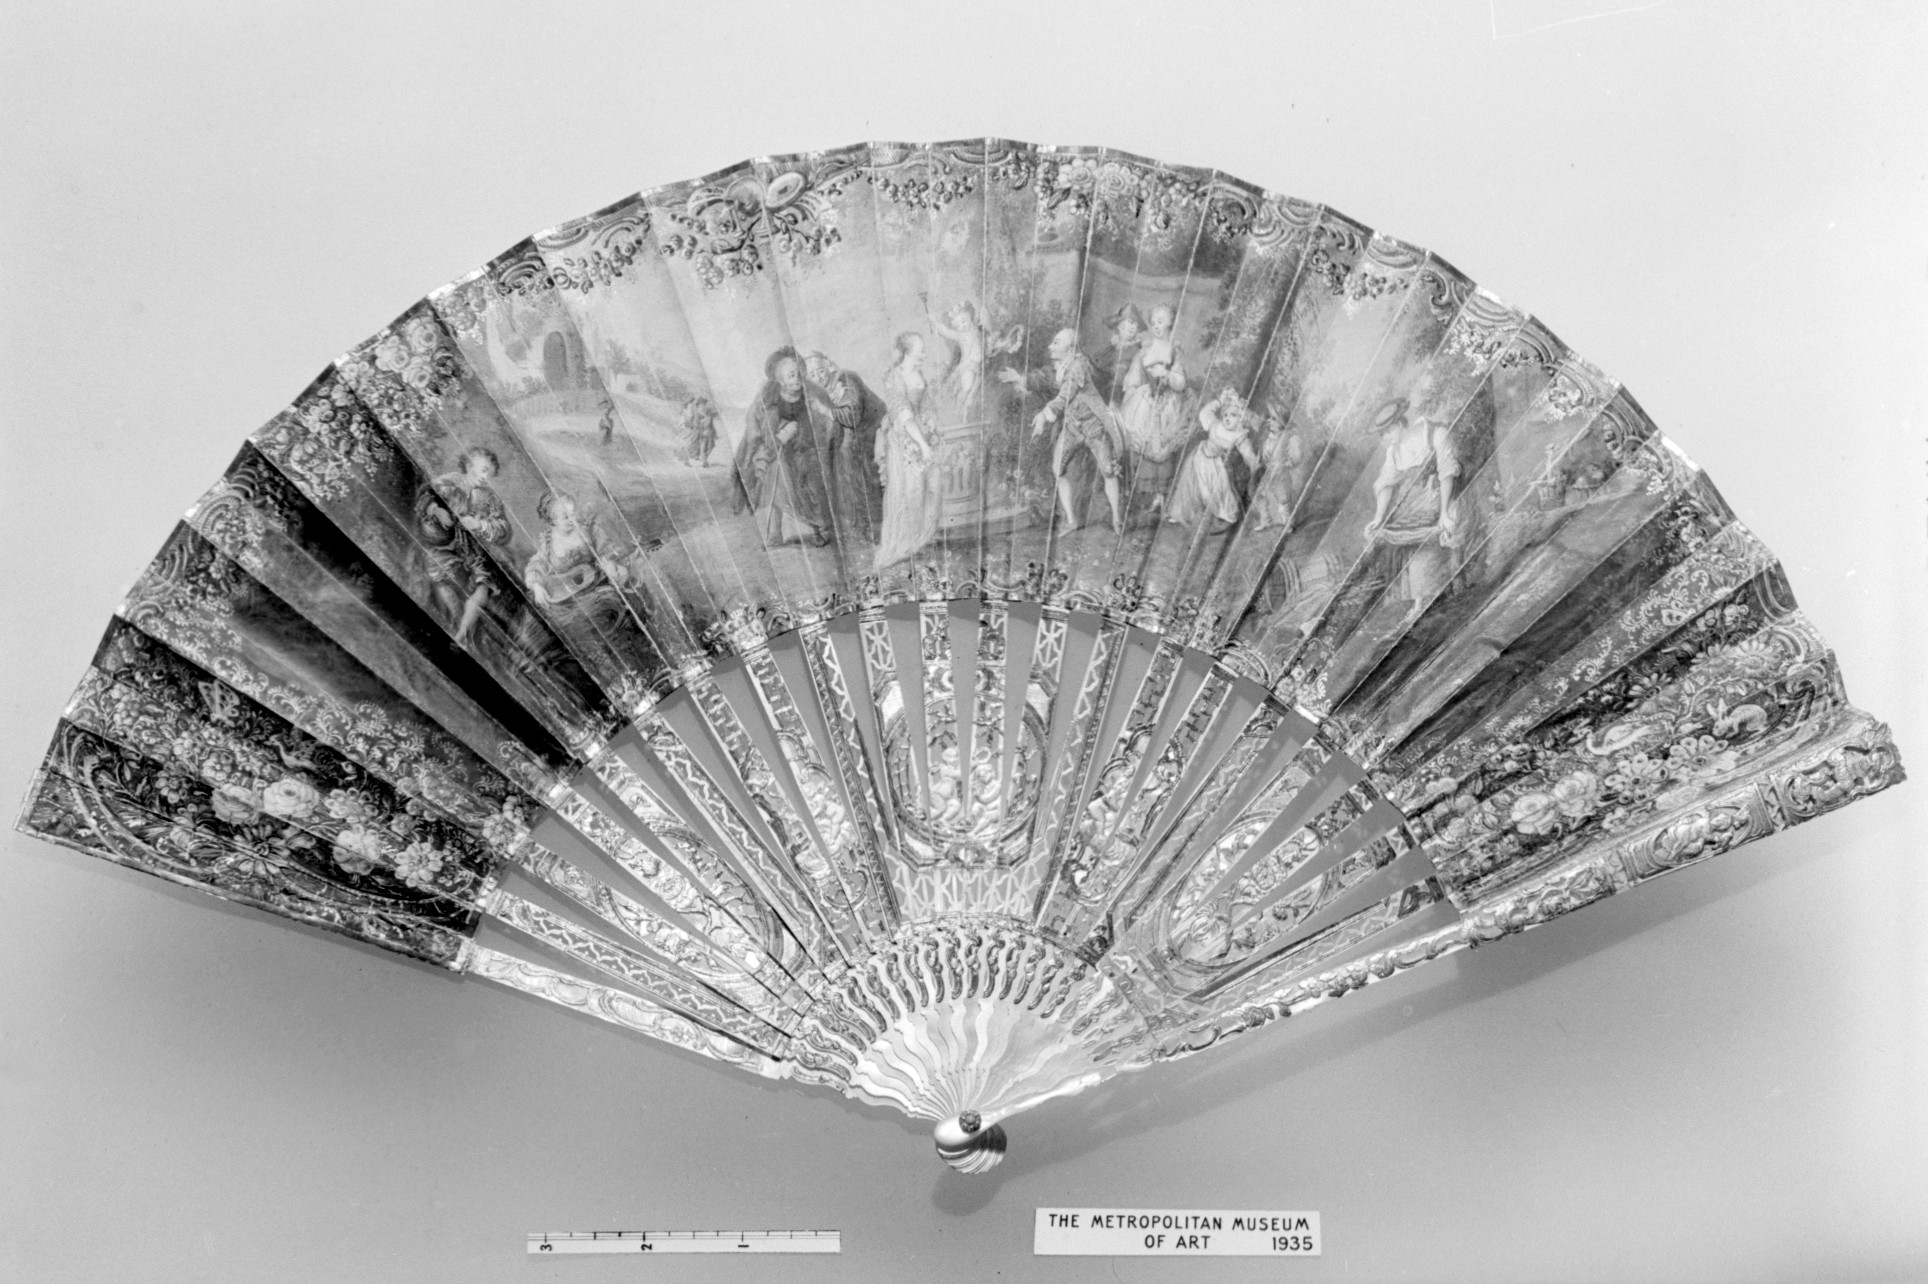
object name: fan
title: Marriage fan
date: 1776-1800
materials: mother of pearl, paper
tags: children,men,women